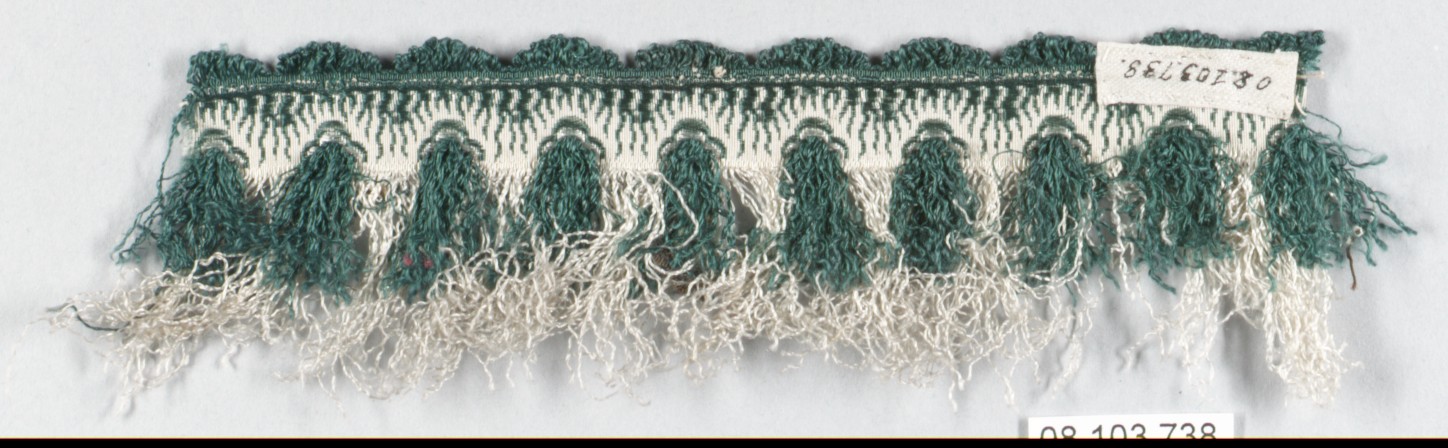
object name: fringe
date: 1701-1900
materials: silk